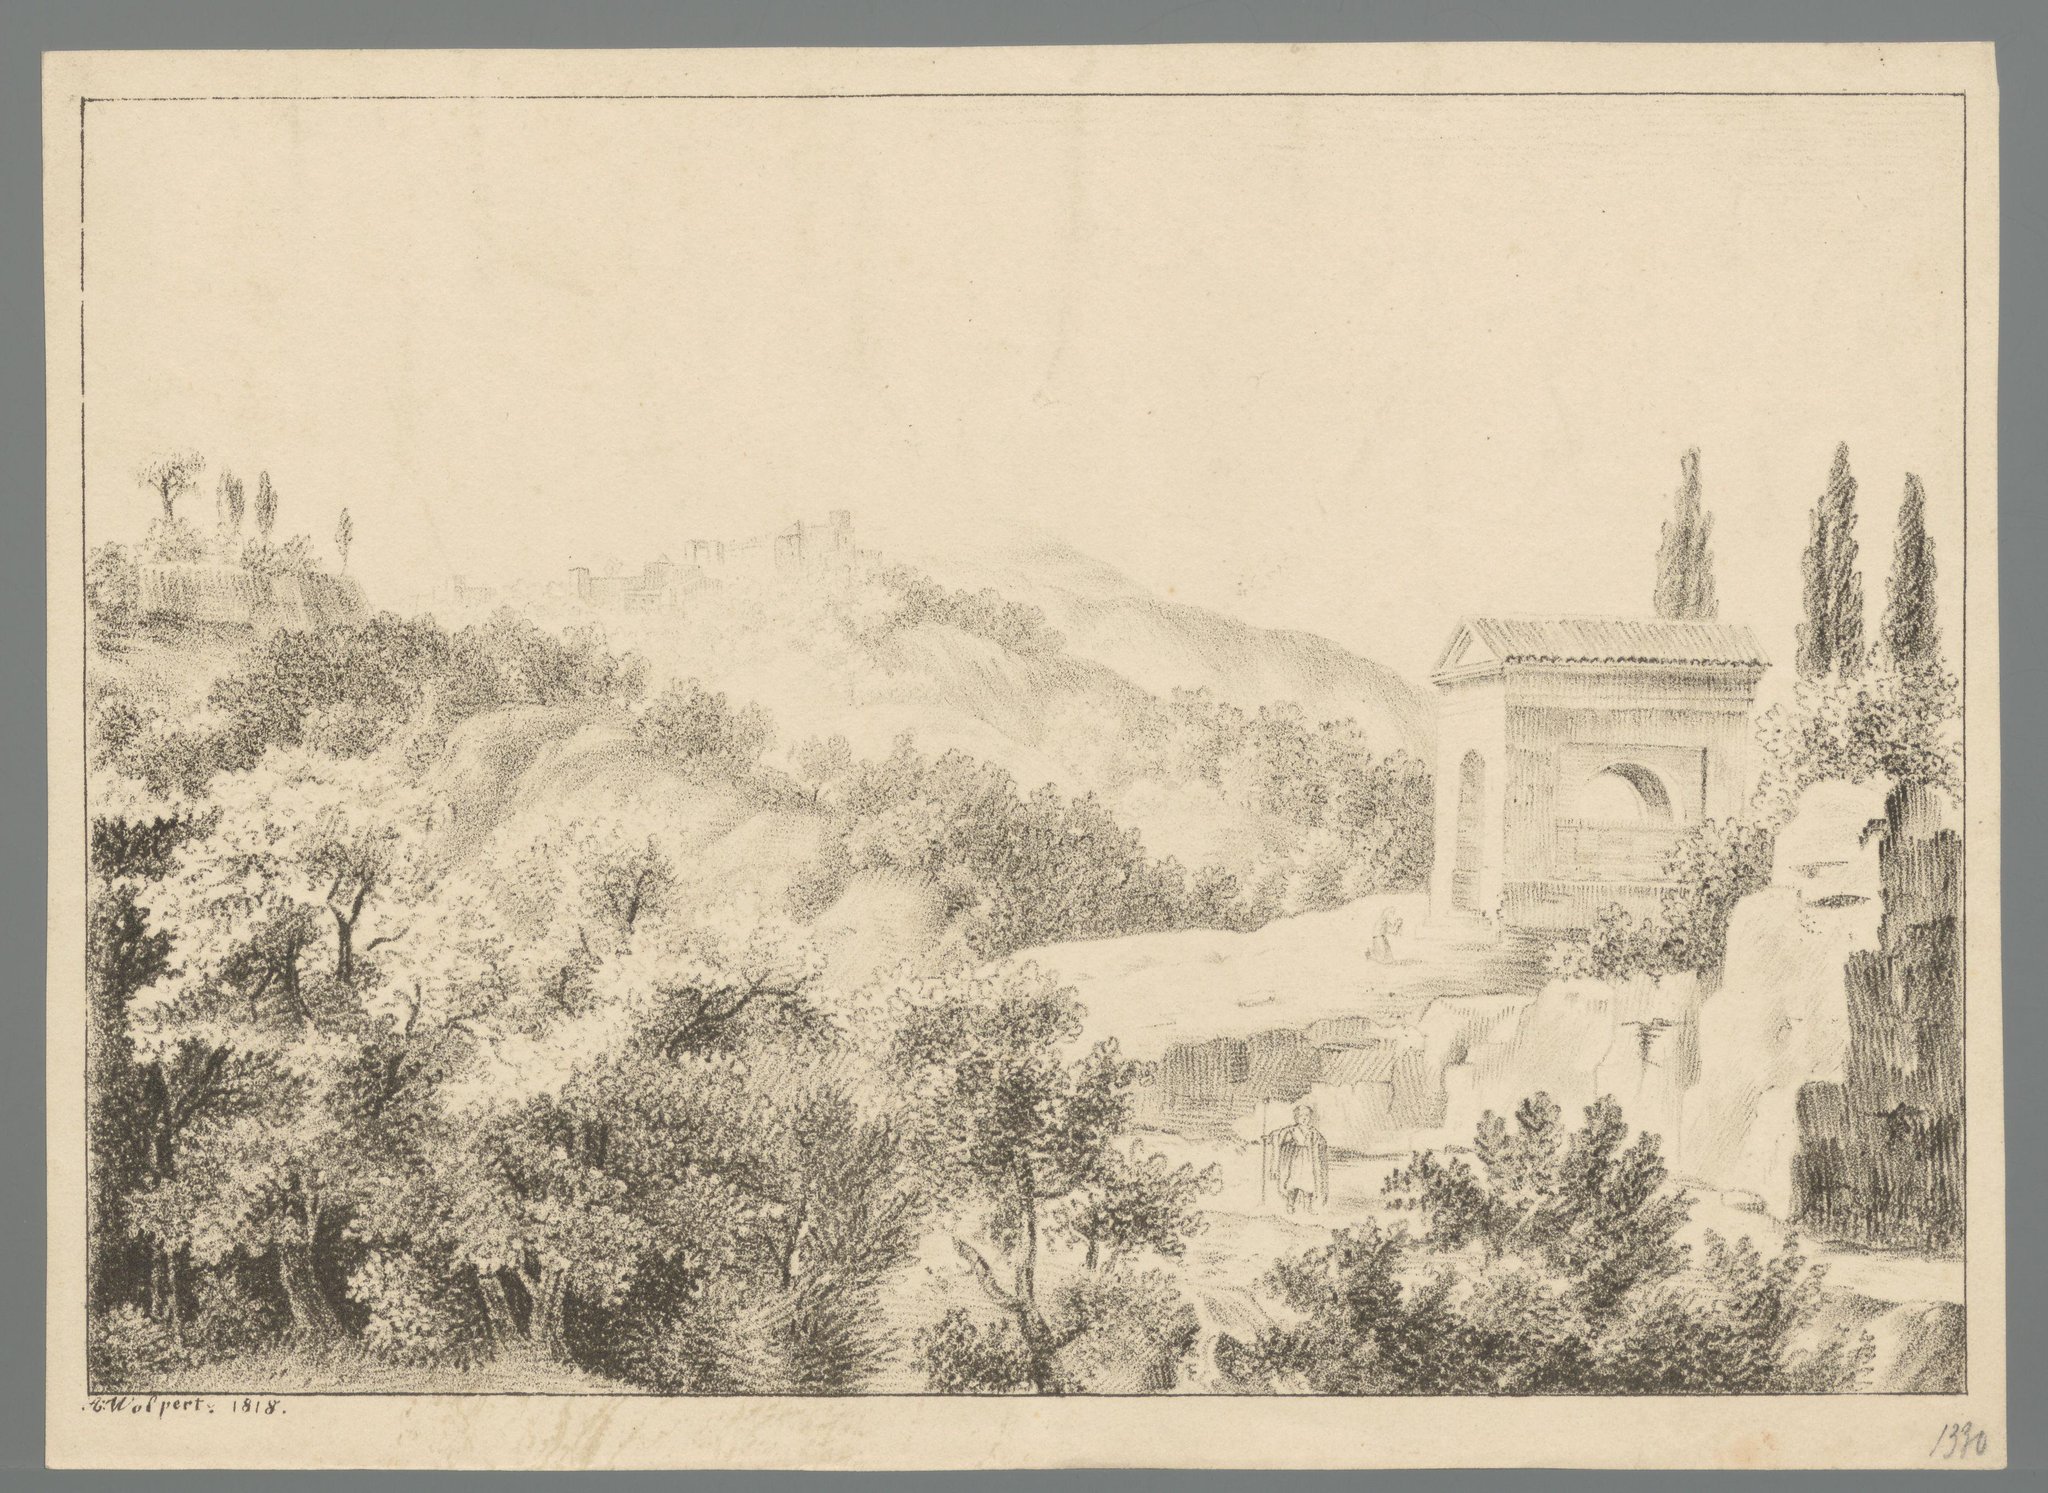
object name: print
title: Berglandschap met tempel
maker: a. wolpert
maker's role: print maker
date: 1818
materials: paper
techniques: lithograph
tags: mountains (+ landscape with figures, staffage), one person praying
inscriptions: collector's mark: Lugt 2228